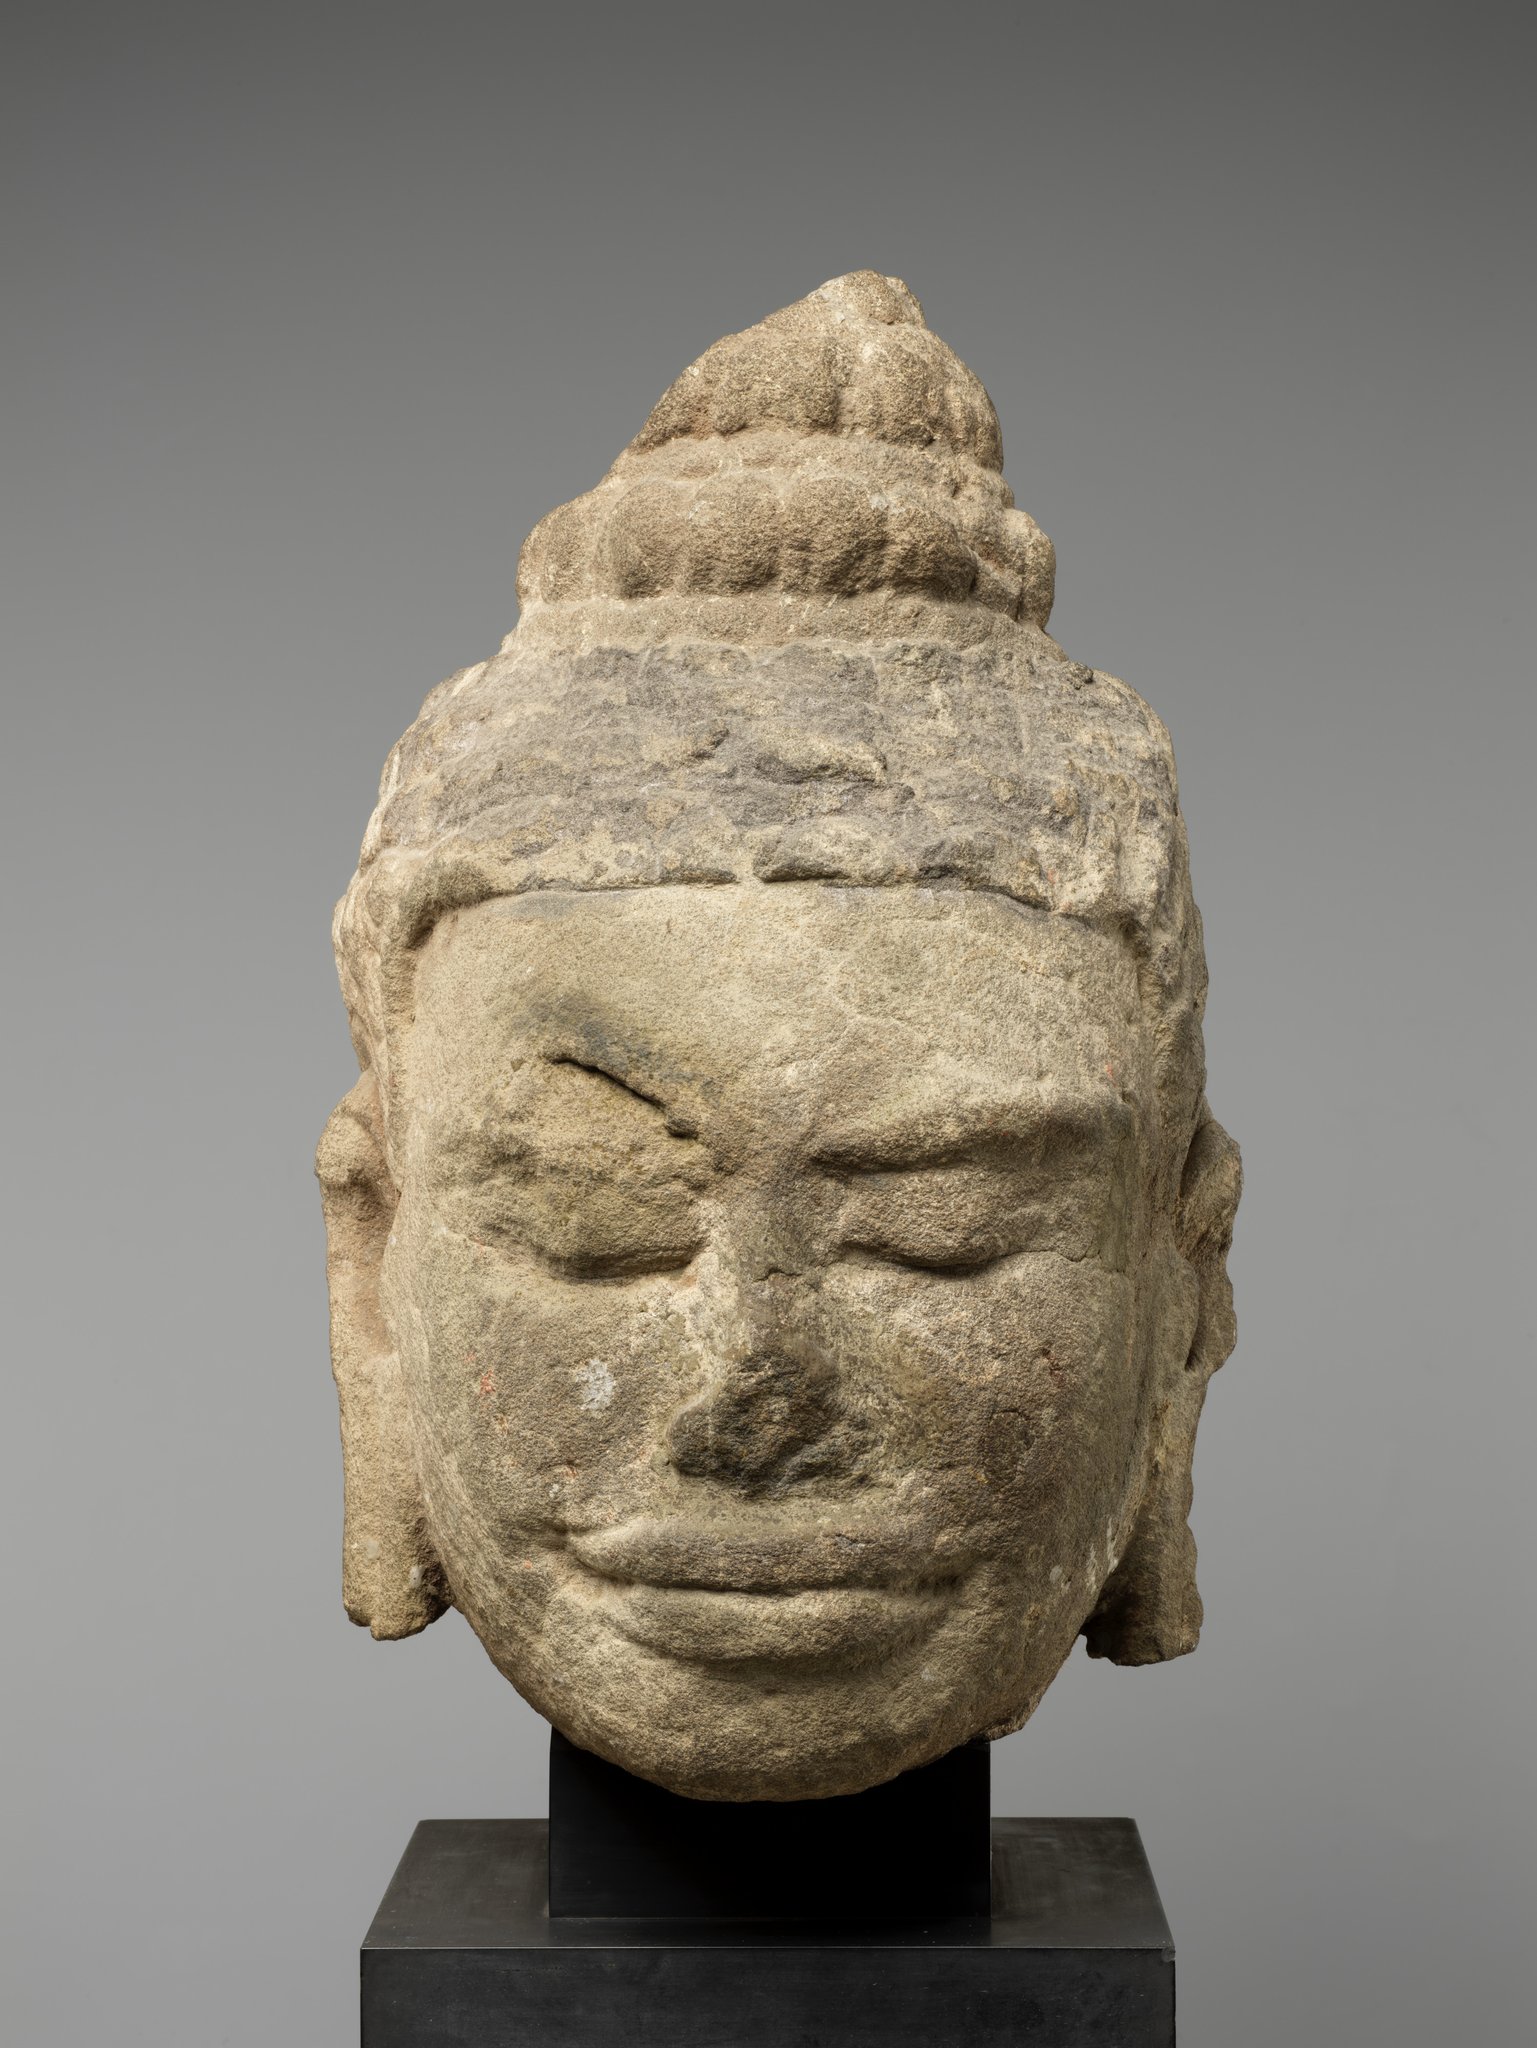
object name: head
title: Head of Buddha or Bodhisattva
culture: cambodian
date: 1101-1200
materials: stone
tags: heads,buddhism,bodhisattvas